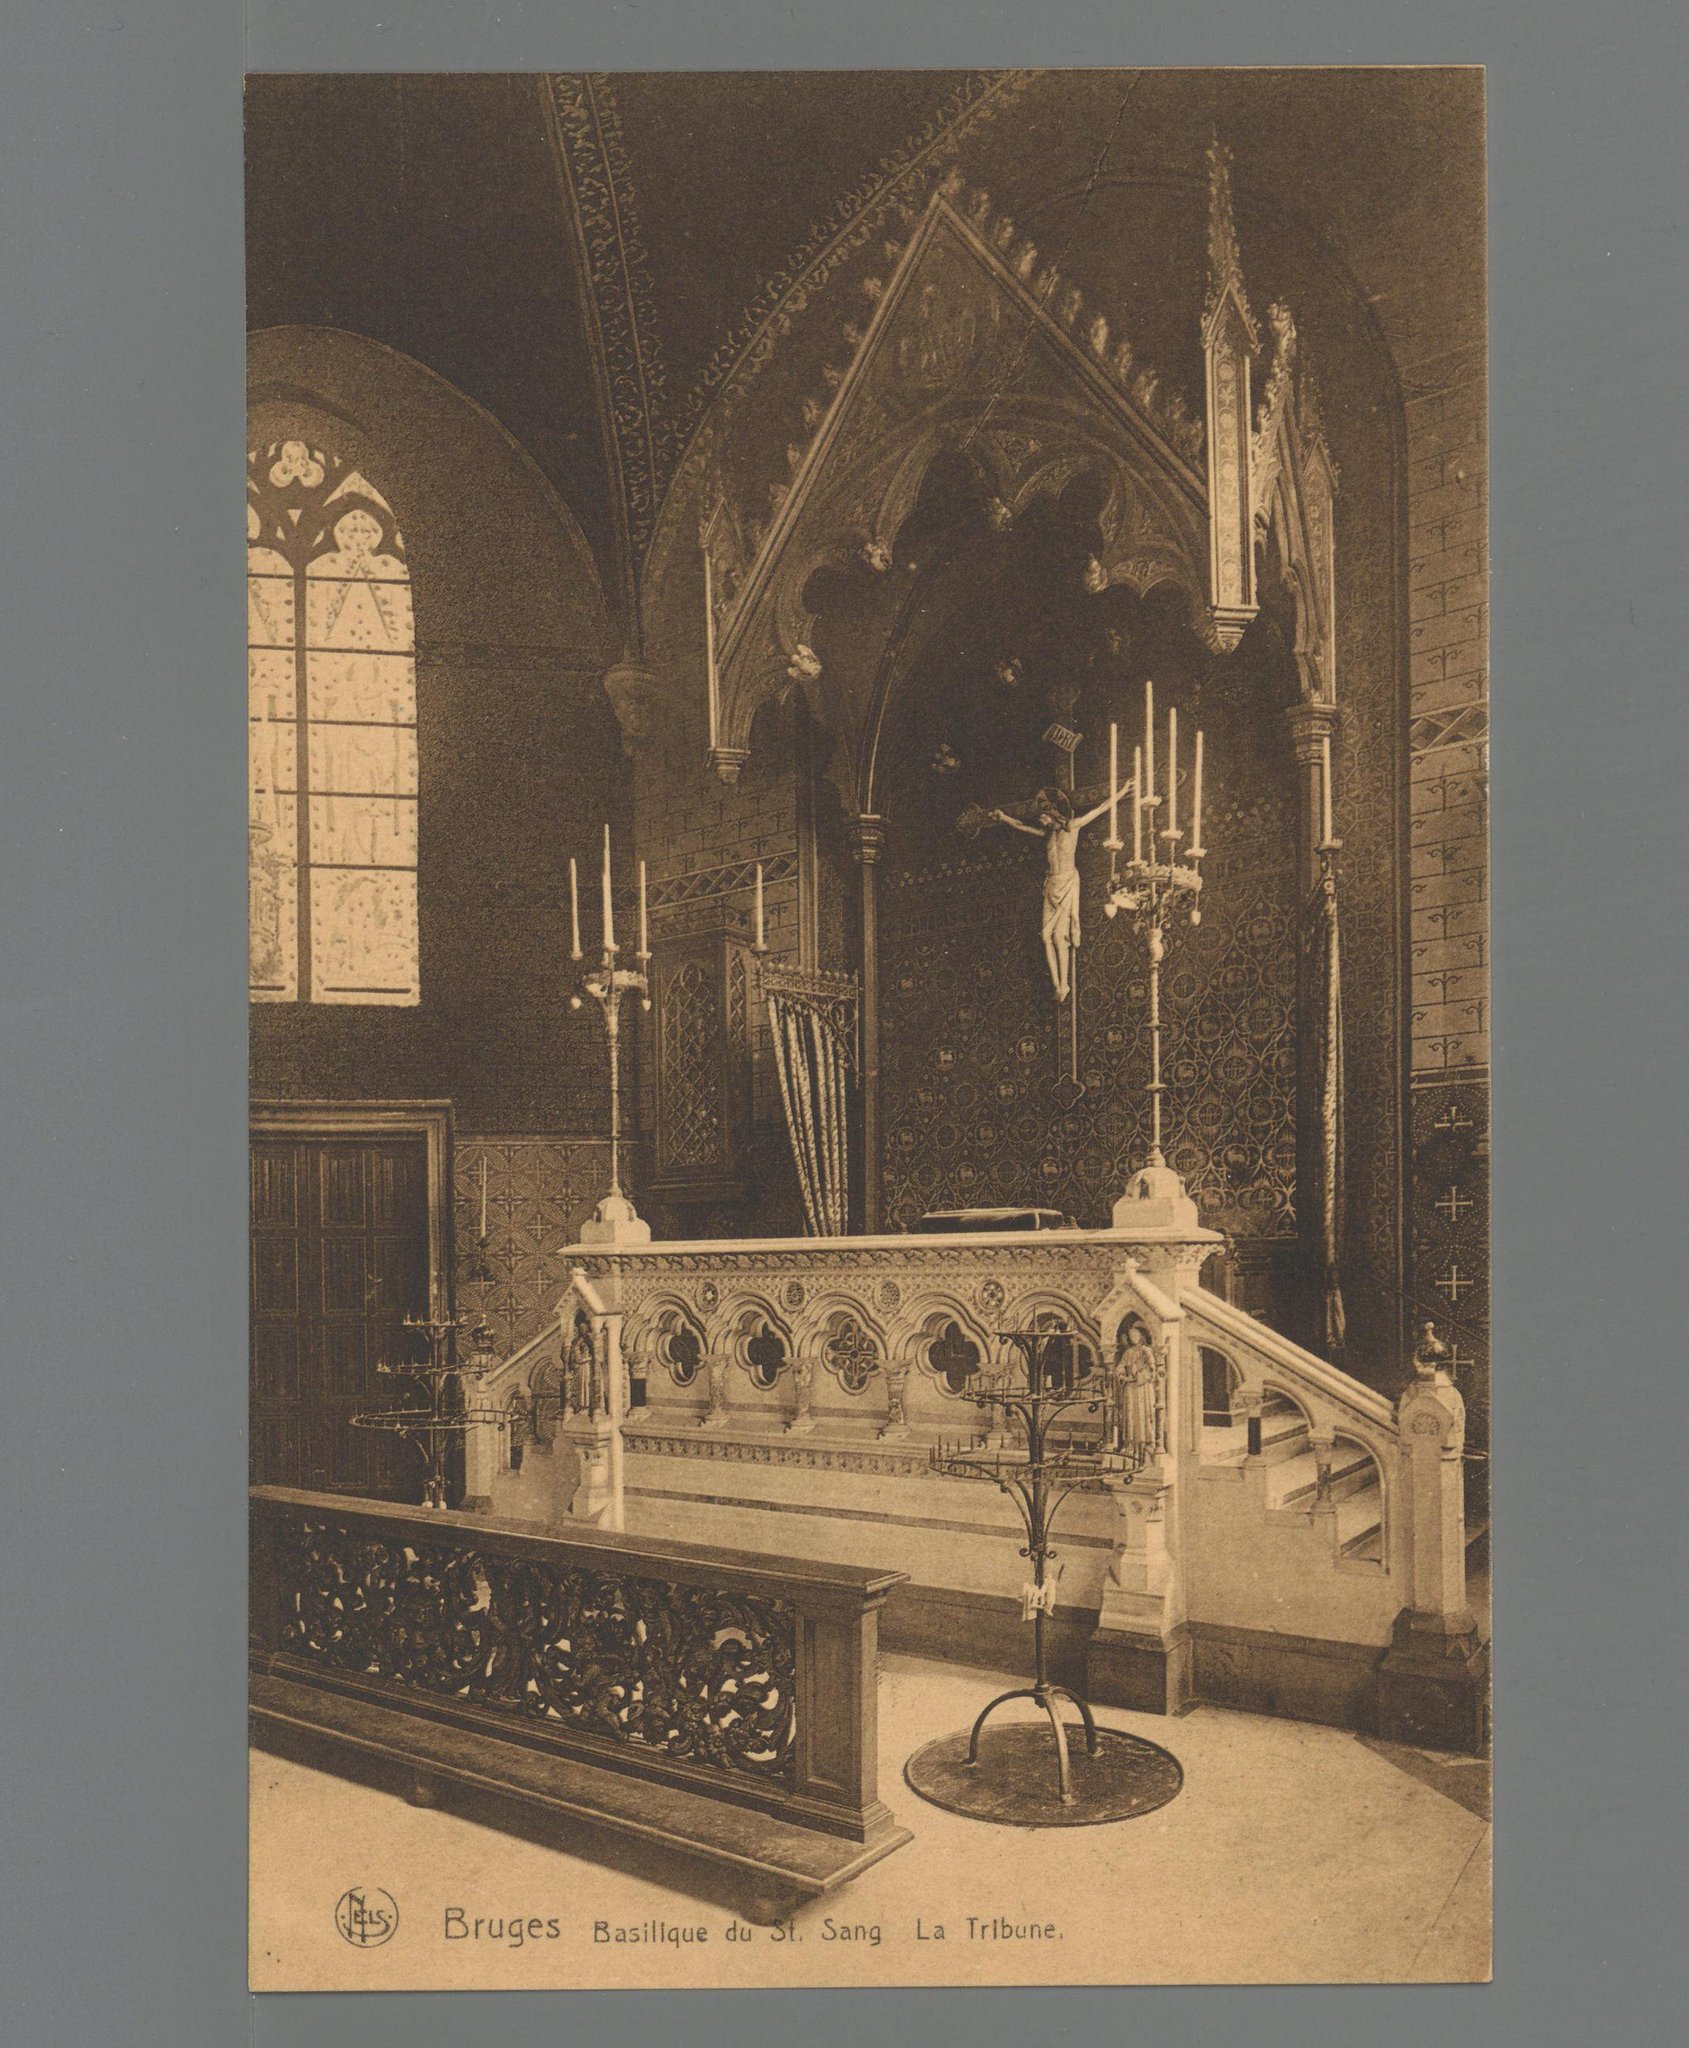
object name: ansichtkaart, prentbriefkaart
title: Série Bruges luxe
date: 1913-1930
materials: cardboard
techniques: photograph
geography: brussels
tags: interior of church